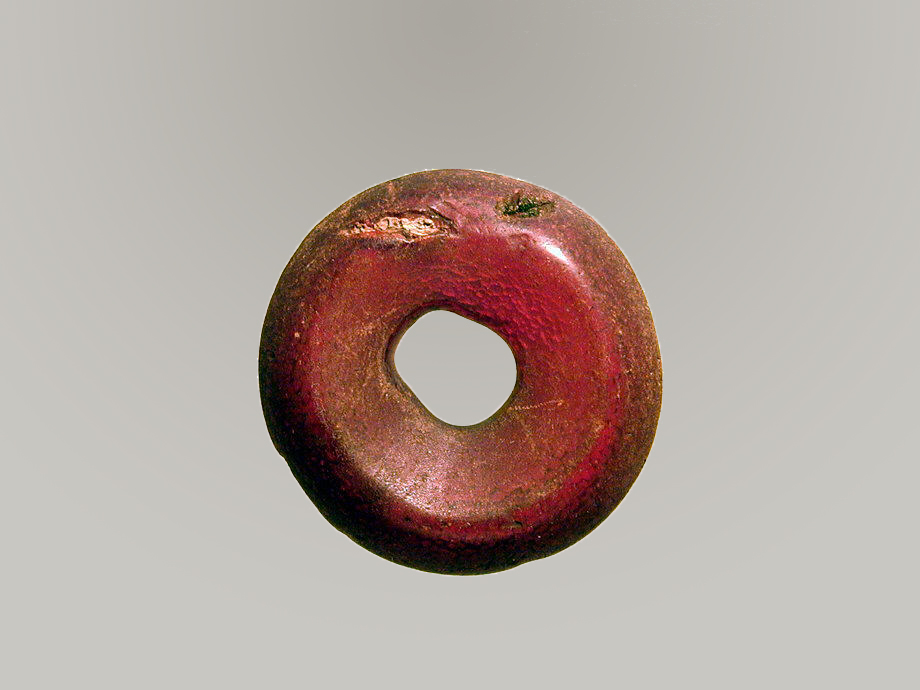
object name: whorl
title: Pierced disk, perhaps from an earring or fibula (safety pin)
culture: etruscan or italic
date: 700-601 BCE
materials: amber